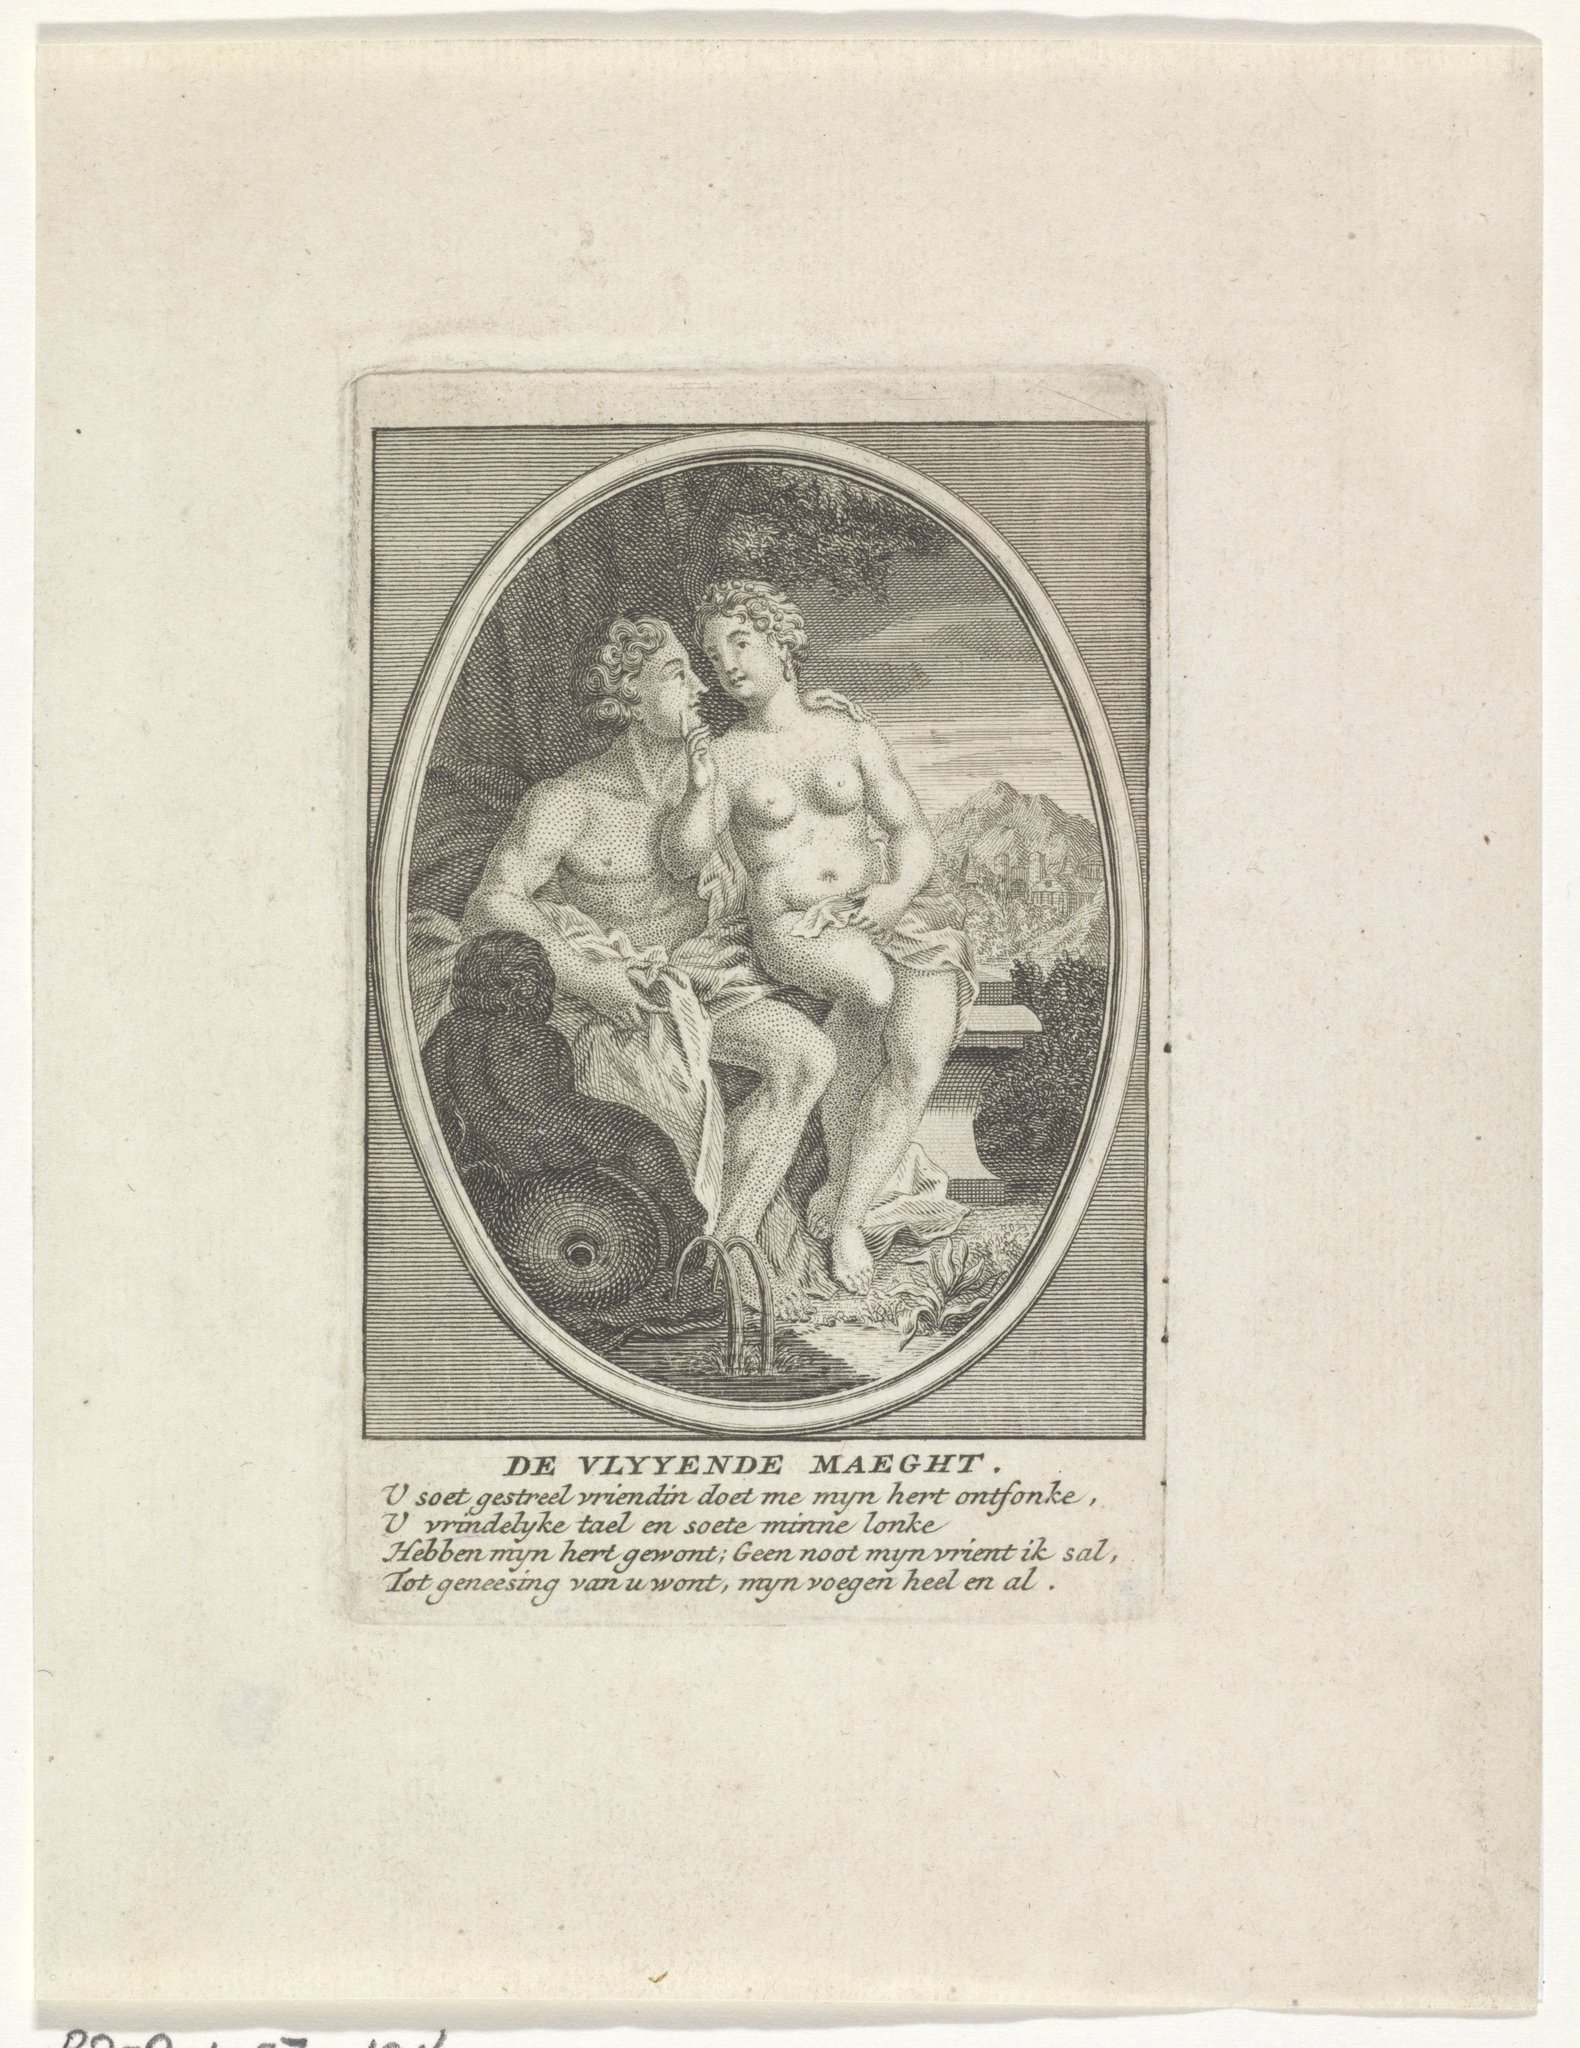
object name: print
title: Vleiende maagd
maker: Anonymous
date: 1700-1900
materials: paper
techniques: engraving, etching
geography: netherlands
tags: couple of lovers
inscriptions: collector's mark: Lugt 2228, collector's mark: Lugt 2760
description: Een jonge naakte vrouw zit op schoot bij een naakte man. Onder de voorstelling een vierregelig vers in het Nederlands.